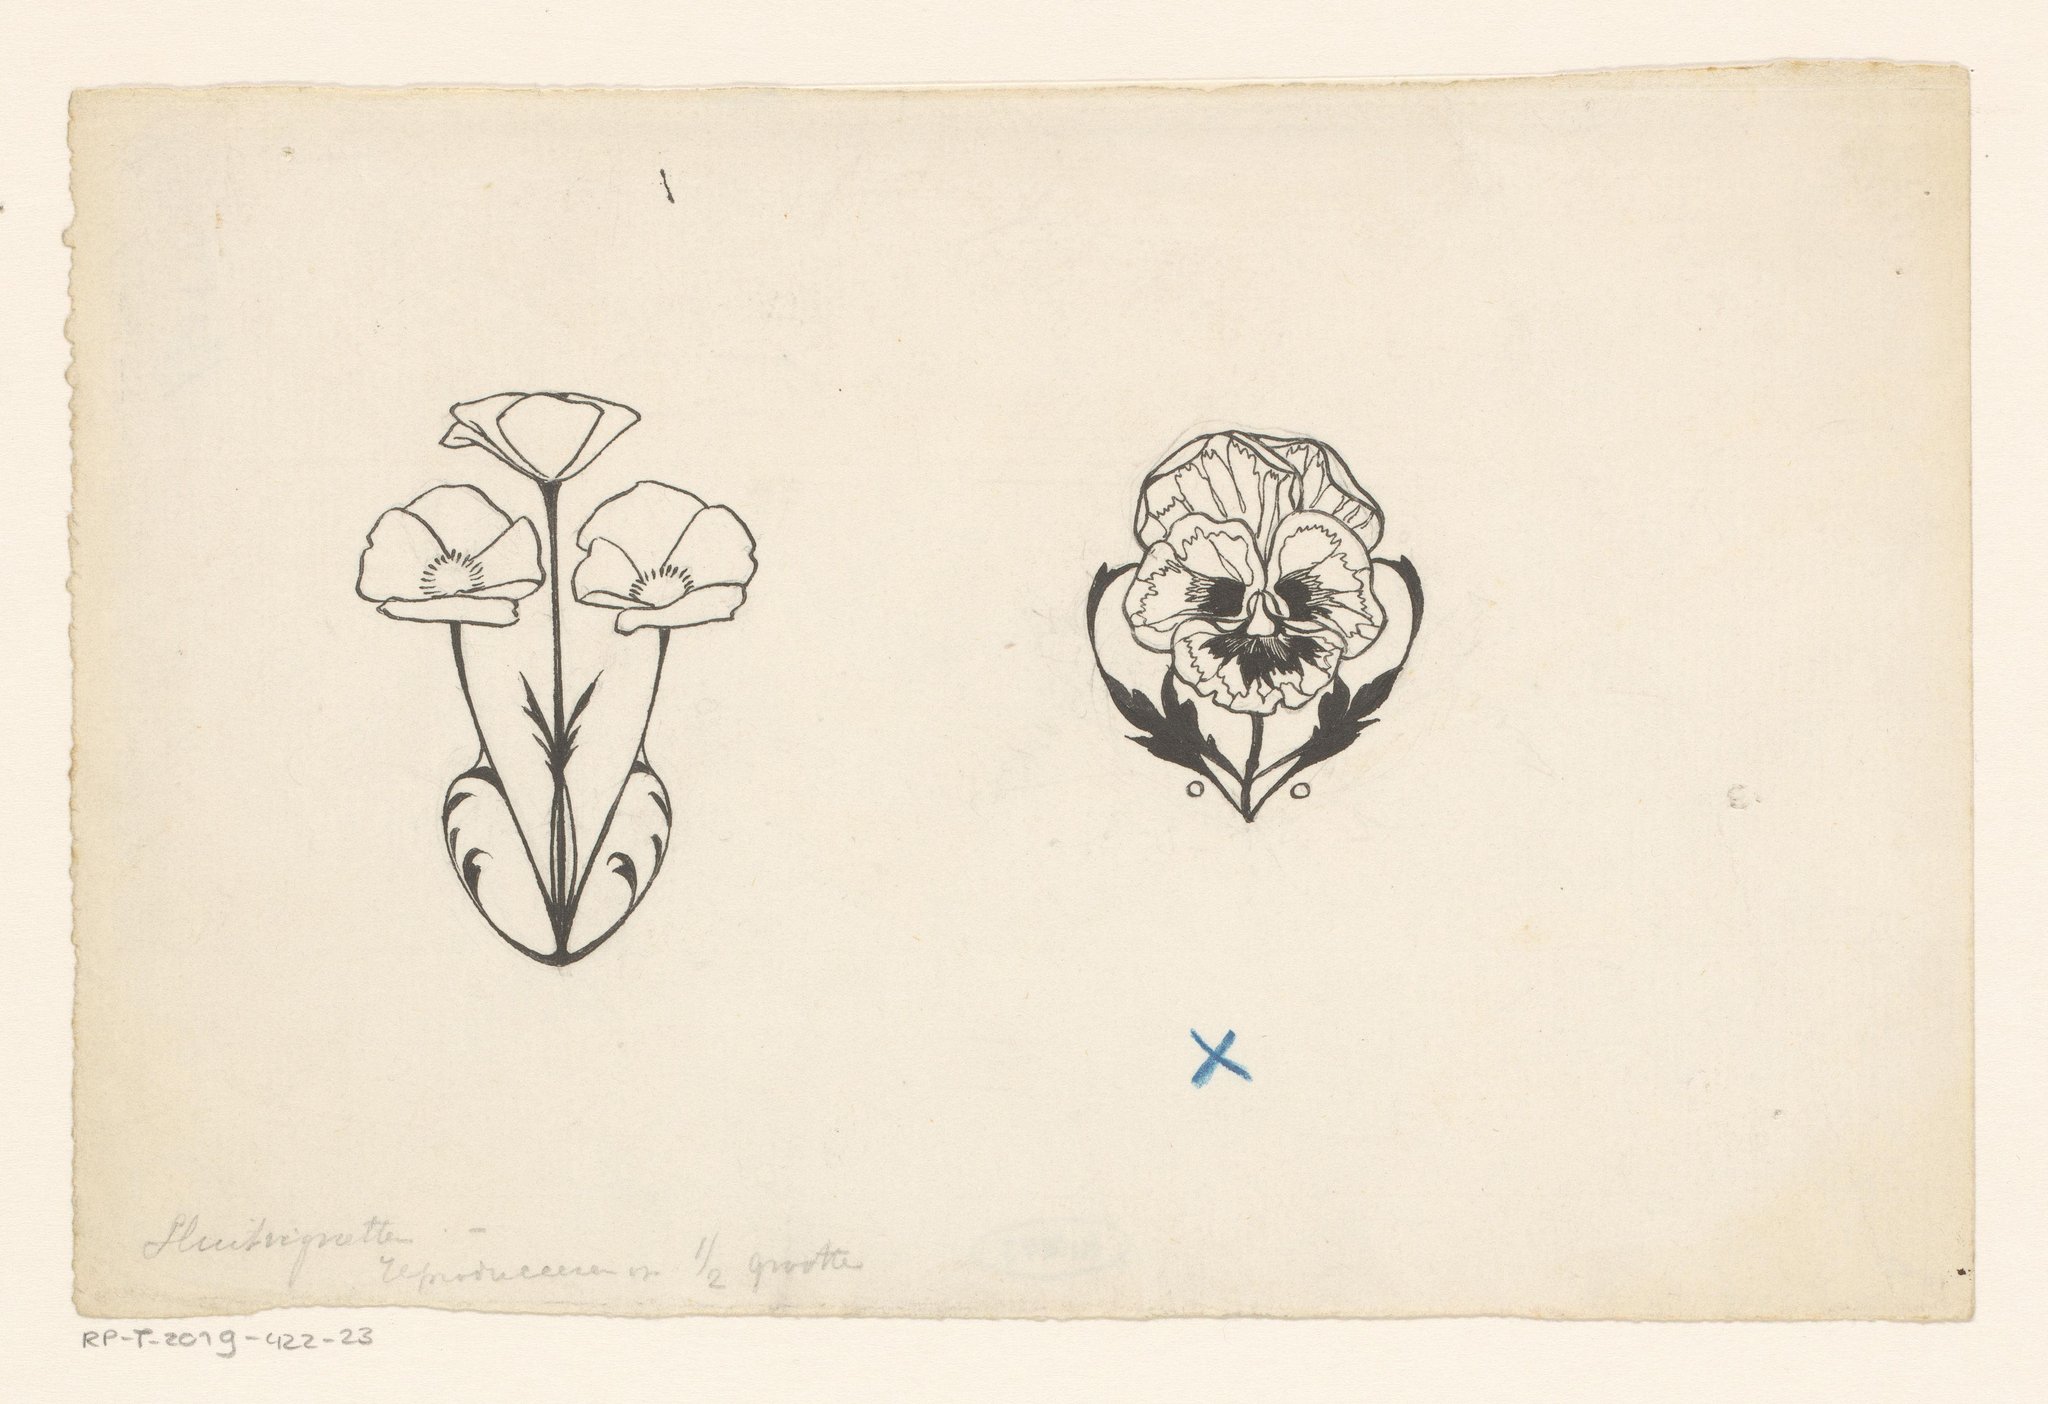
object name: drawing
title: Twee sluitvignetten met bloemen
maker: willem wenckebach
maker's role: designer, draughtsman, painter, print maker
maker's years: 1860-1937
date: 1870-1937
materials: ink, paper, pencil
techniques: pen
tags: flowers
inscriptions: :, collector's mark: Lugt 2228, annotation: ‘Sluitvignetten’